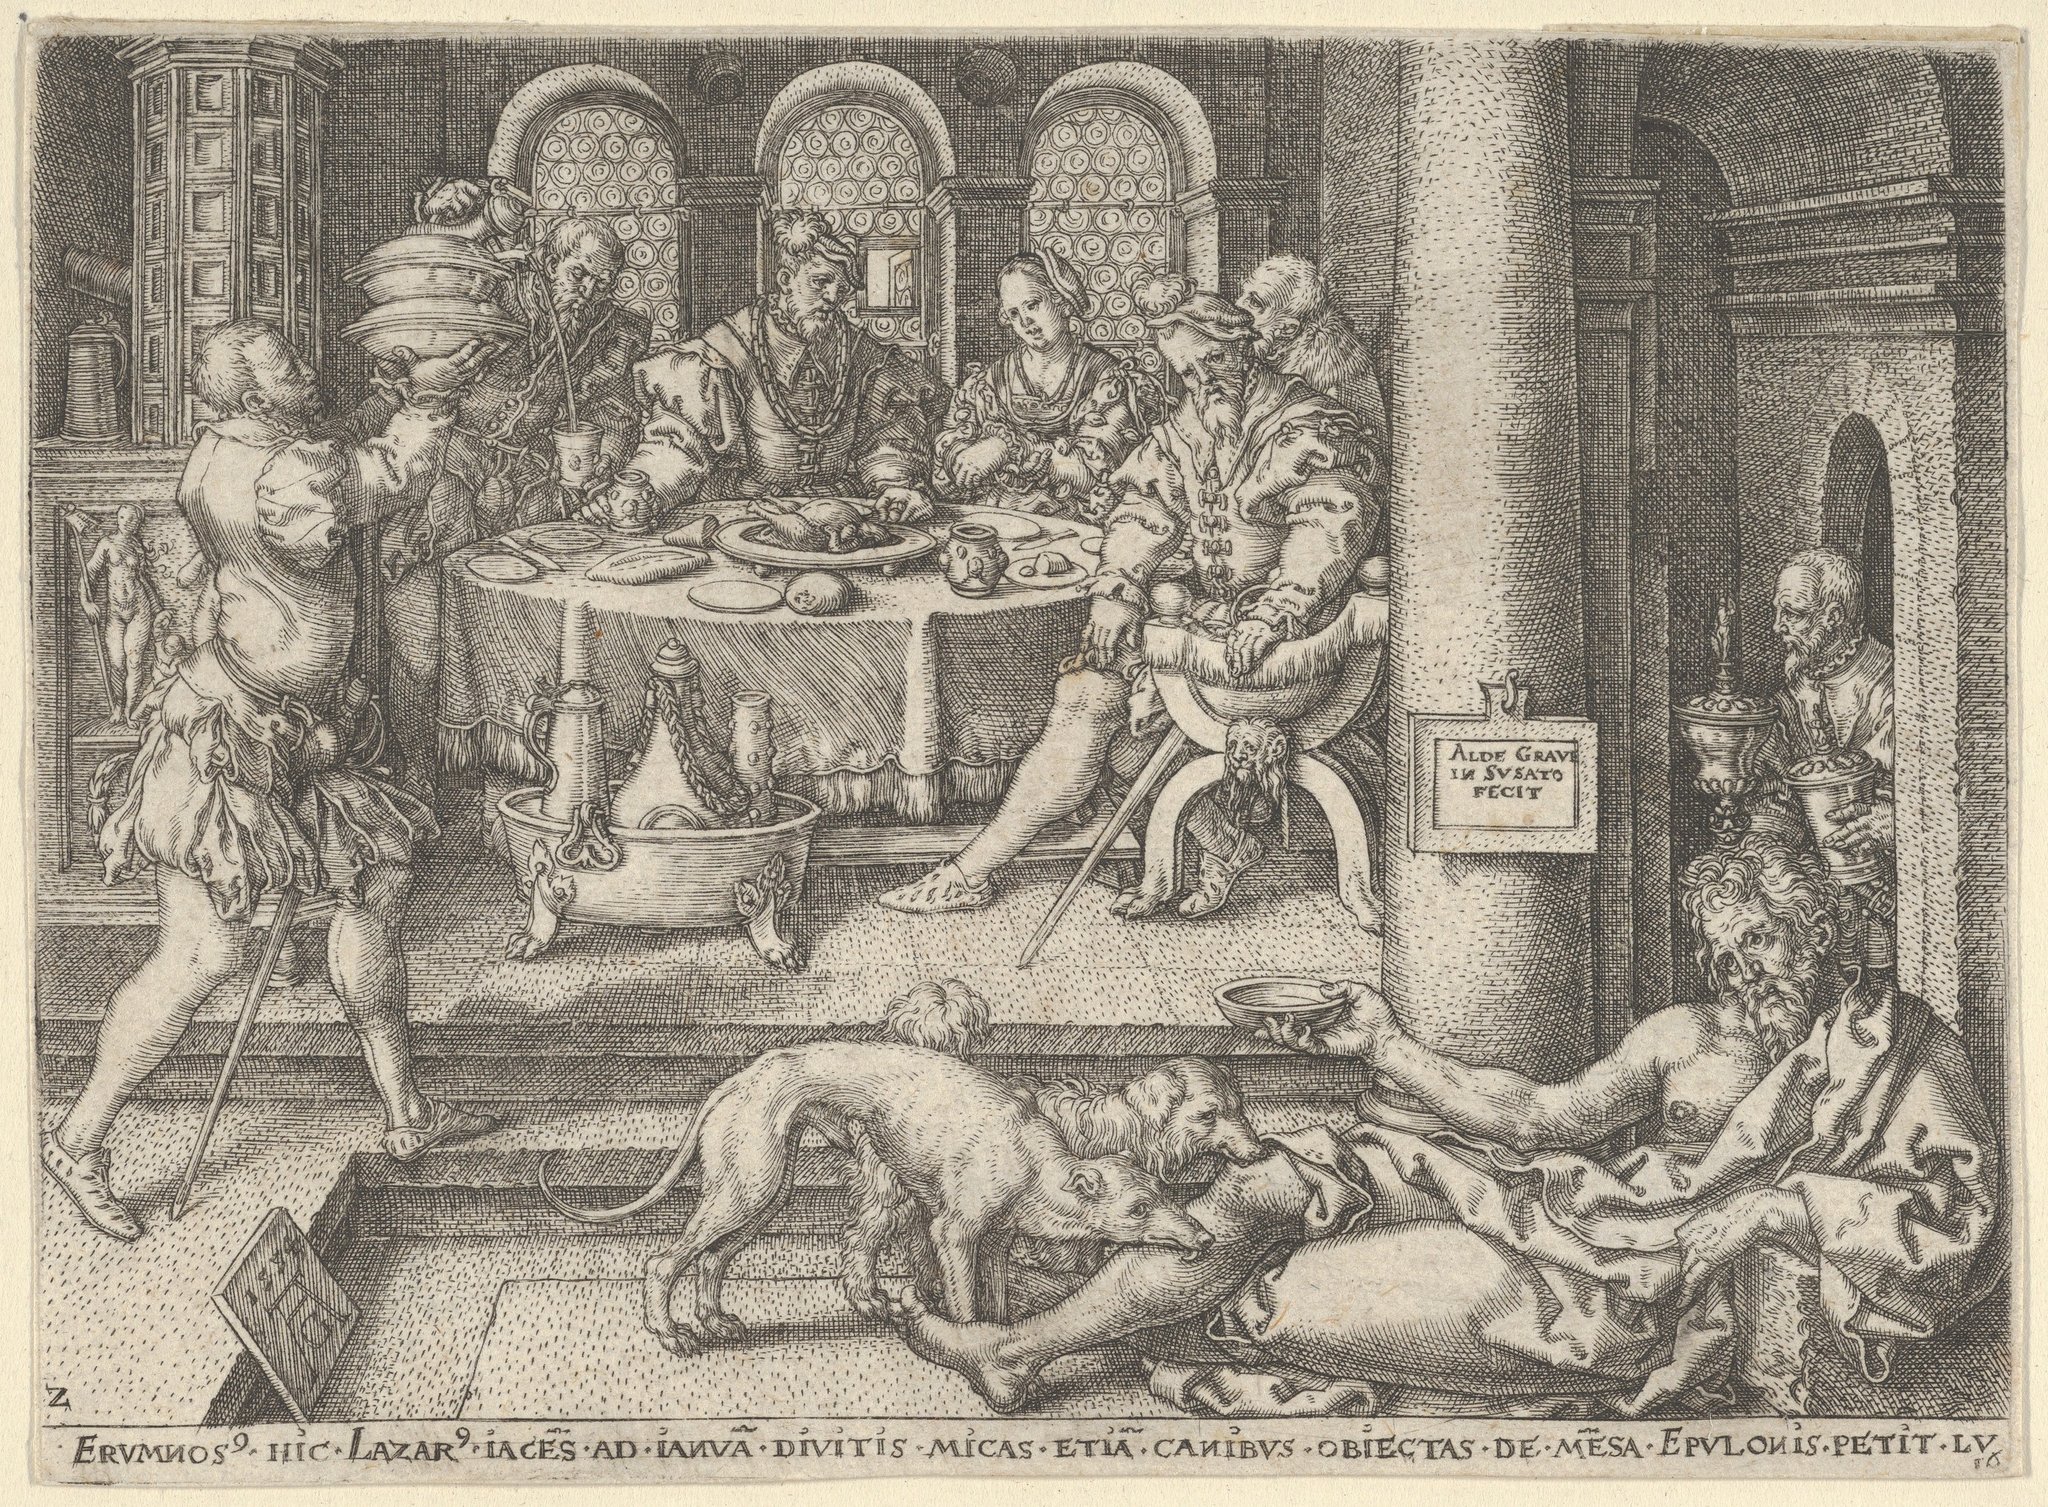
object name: print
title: Lazarus at the Rich Man's Gate, from "The Parable of the Rich Man and Lazarus"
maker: heinrich aldegrever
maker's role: artist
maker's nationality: german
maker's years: 1502-1561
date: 1554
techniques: engraving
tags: food,interiors,men,women,dogs,dining,ewers